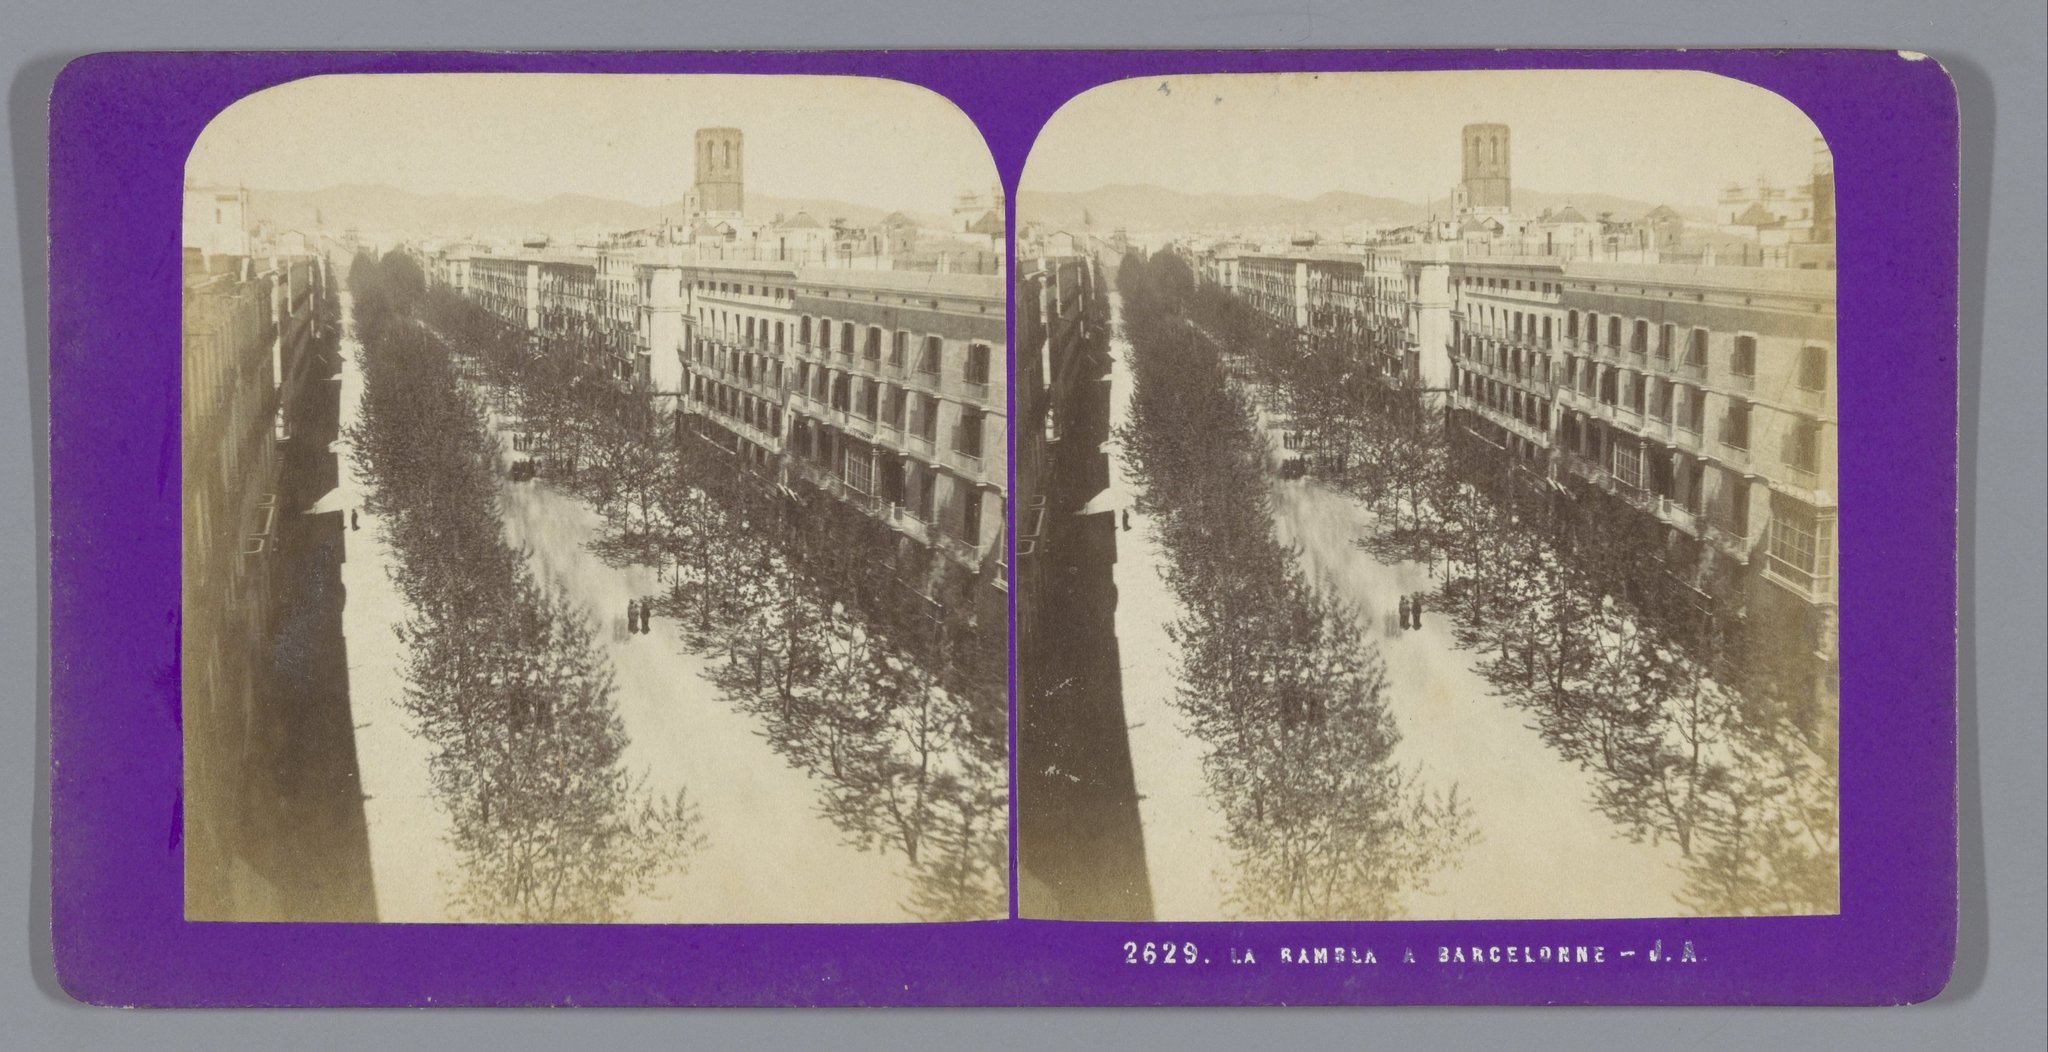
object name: stereograph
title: LA RAMBLA A BARCELONNE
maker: jean andrieu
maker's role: fotograaf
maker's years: 1816-1872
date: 1862-1876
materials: cardboard, photographic support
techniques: albumen print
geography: barcelona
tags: street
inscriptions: number: ‘2629.’